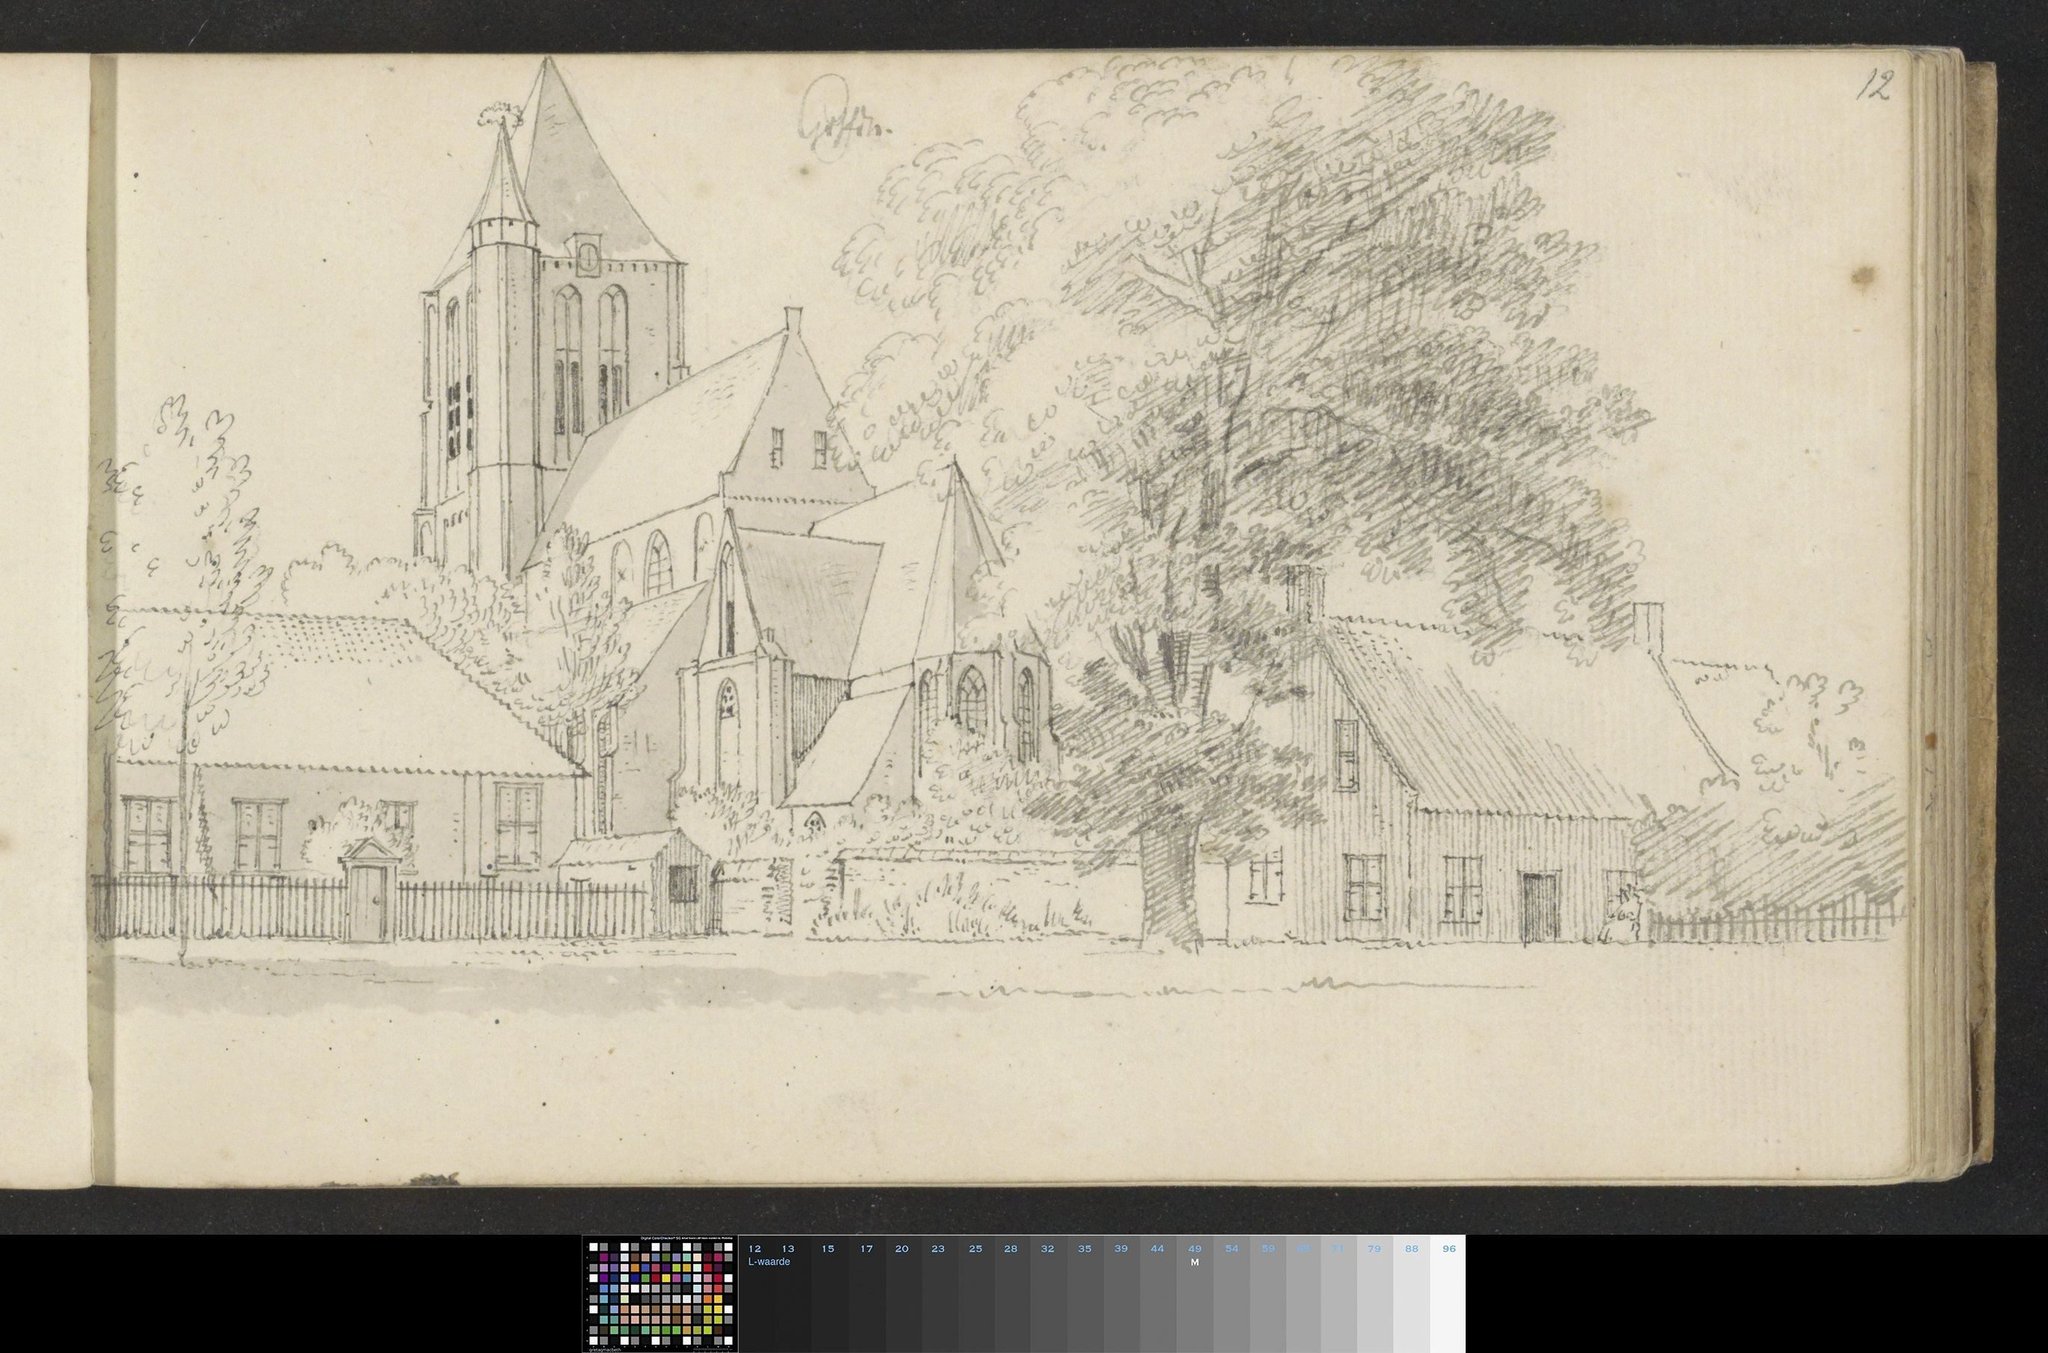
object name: sketchbook leaf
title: Gezicht te Geffen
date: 1701-1759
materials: ink, paper, pencil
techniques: brush, pen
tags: prospect of village, silhouette of village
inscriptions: annotation: ‘Geffen’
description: Blad 12 recto uit een schetsboek met 65 bladen.